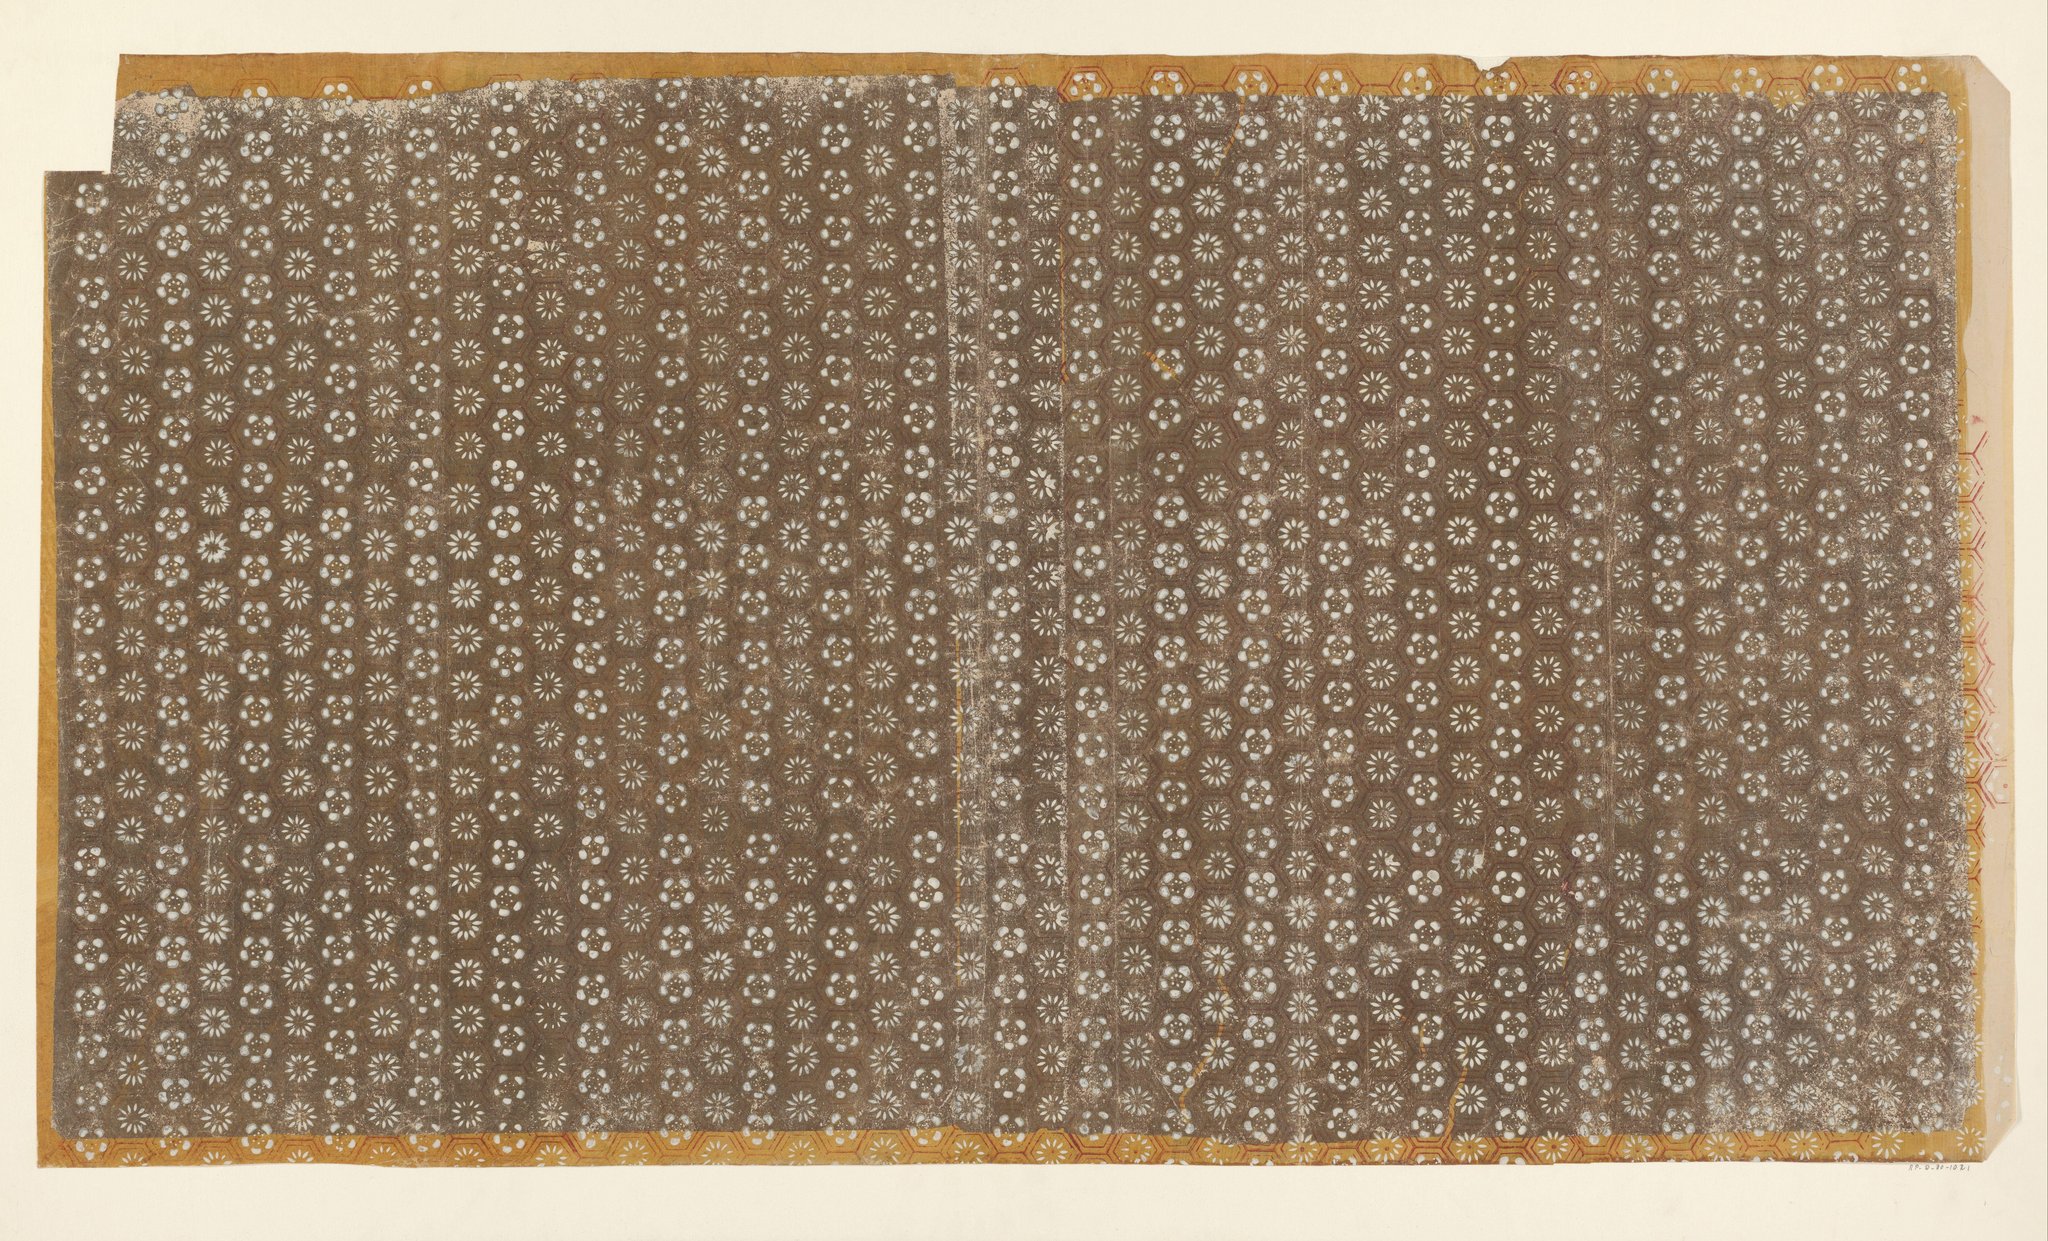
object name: decorated paper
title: Blad met rasterpatroon van zeshoeken gevuld met bloemmotieven (één van zes identieke bladen)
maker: Anonymous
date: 1850-1950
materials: paper, gold leaf, paint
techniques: printing block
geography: japan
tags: ornament ~ geometric motifs, ornament derived from plant forms